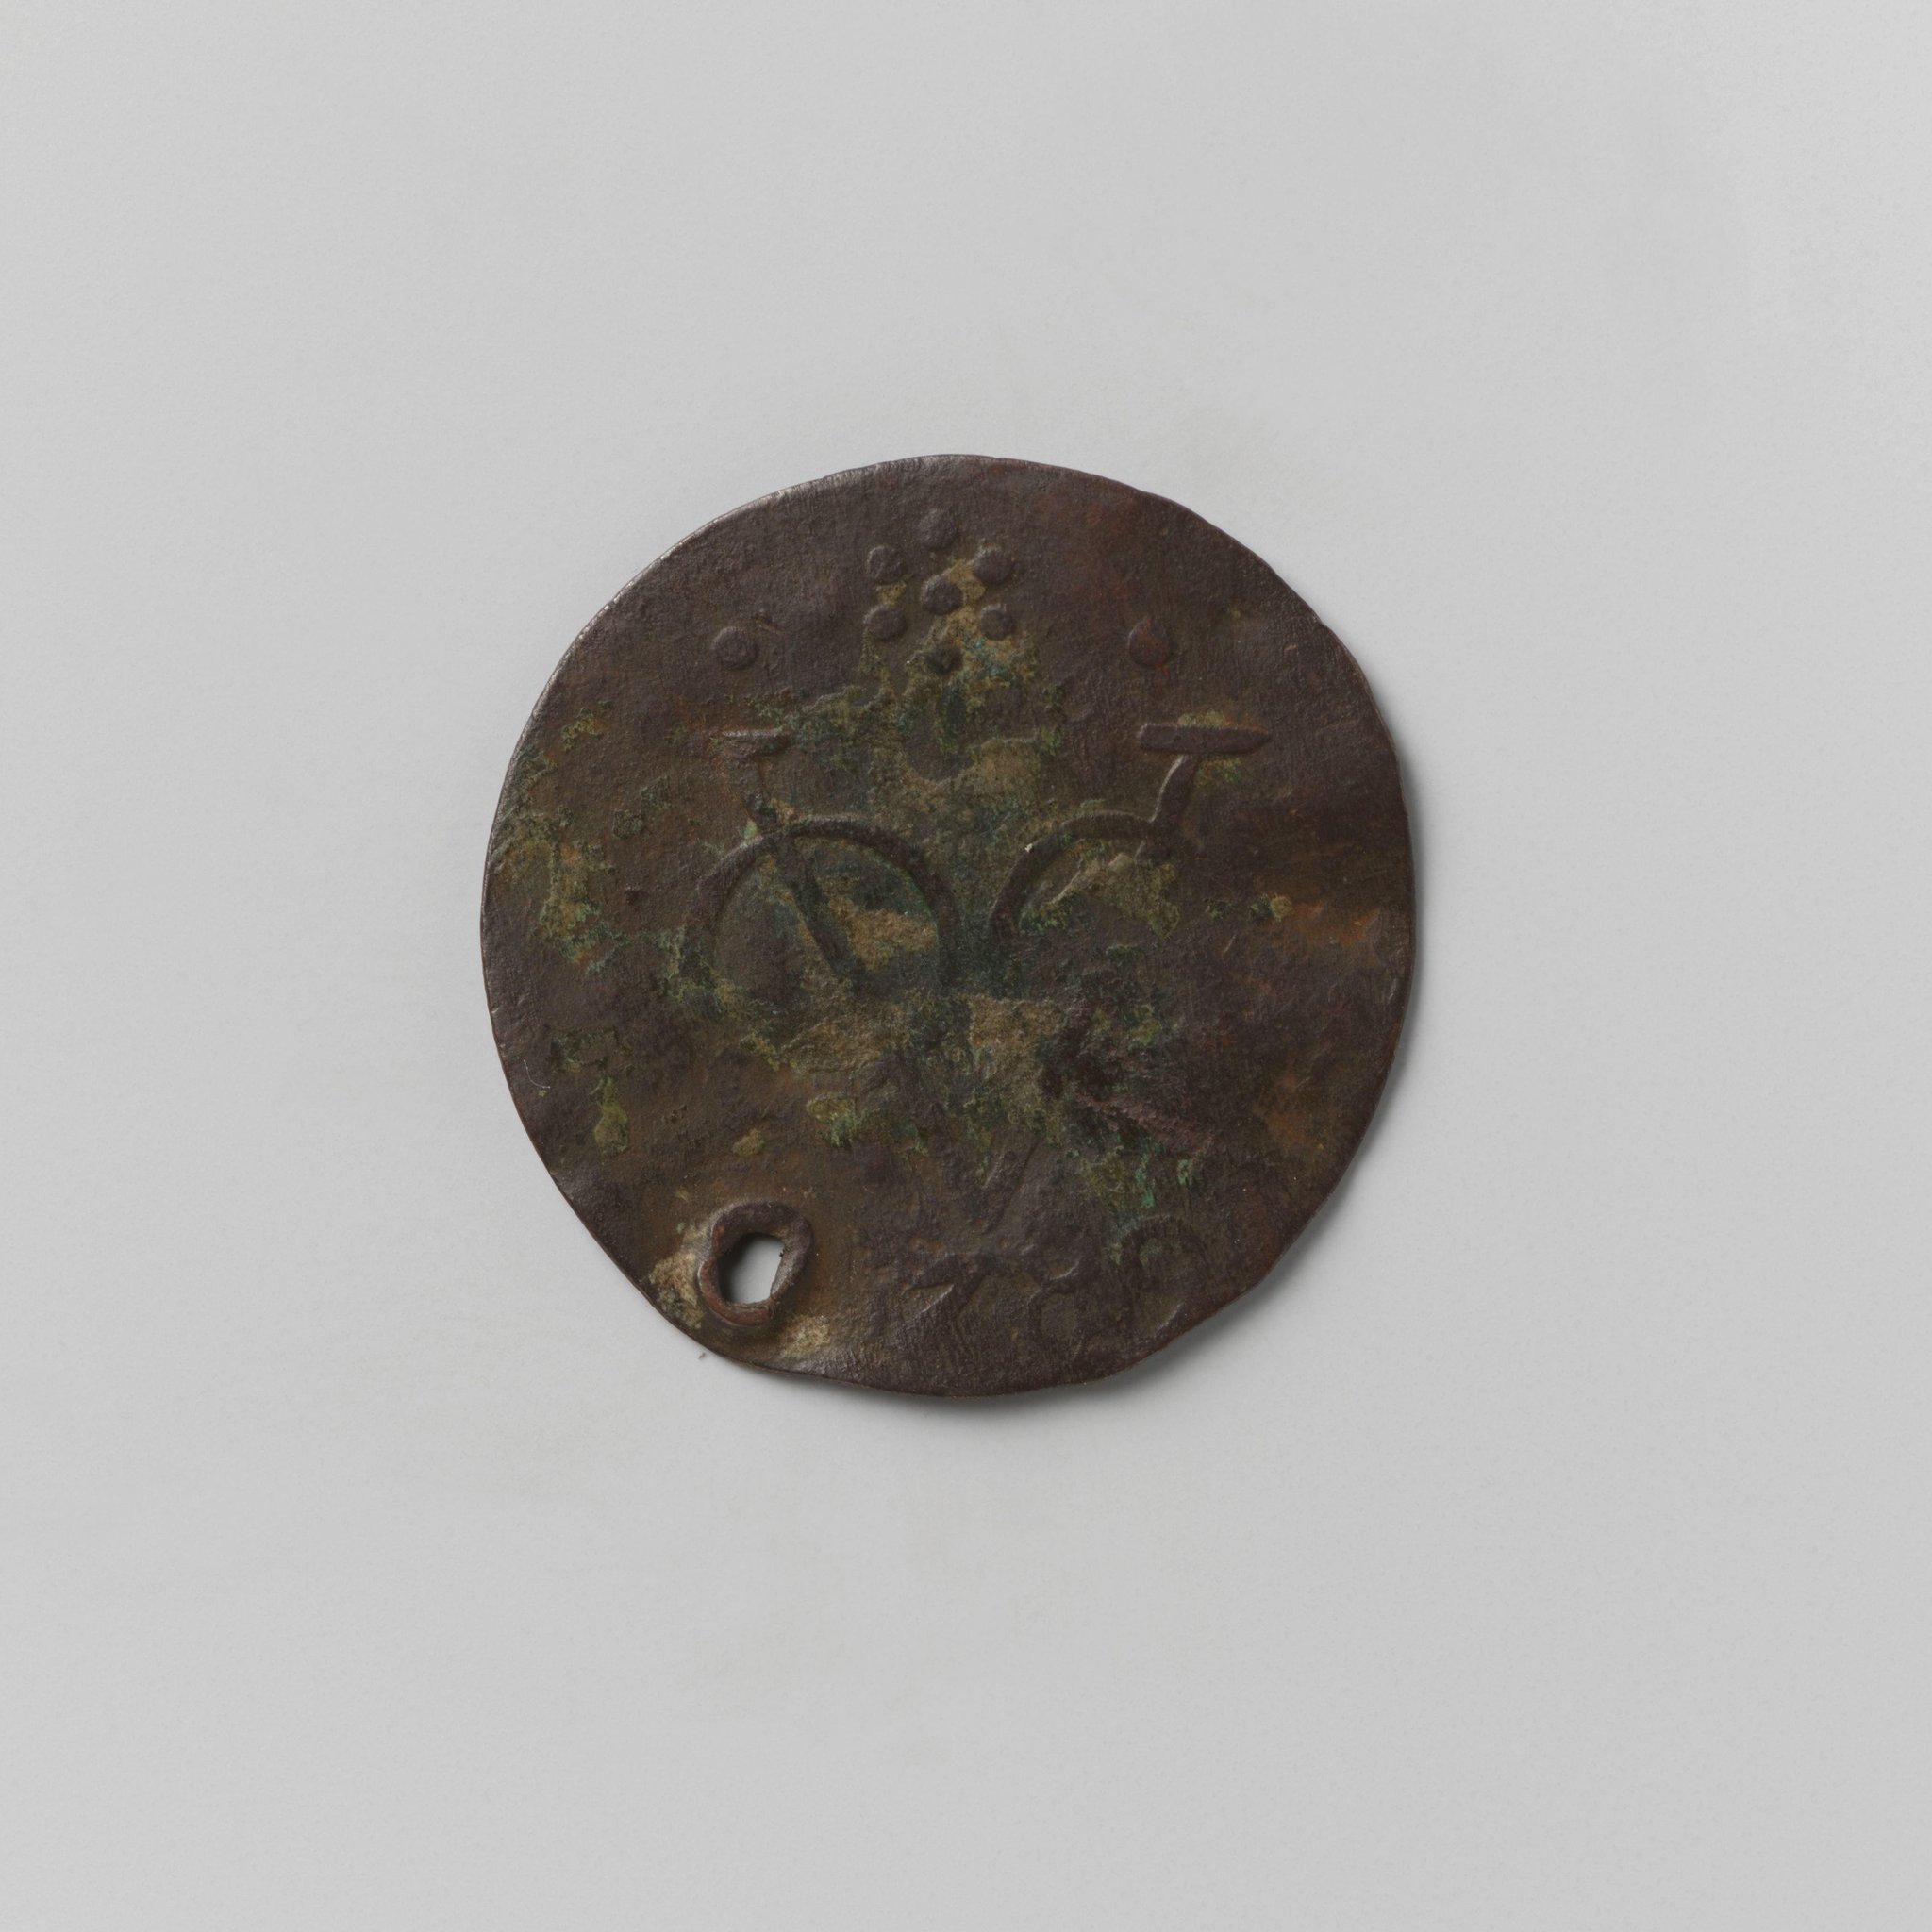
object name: coin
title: Nabootsing van een duit van de VOC, 1789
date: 1789-1830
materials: copper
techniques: striking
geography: banjarmasin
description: Koperen munt. Nabootsing van duit van de VOC. Voorzijde: fictief wapenschild, waarin twee Arabische lettertekens. Keerzijde: monogram van de VOC, waarboven fictief muntteken en waaronder fictief jaartal. Gat in muntplaatje.